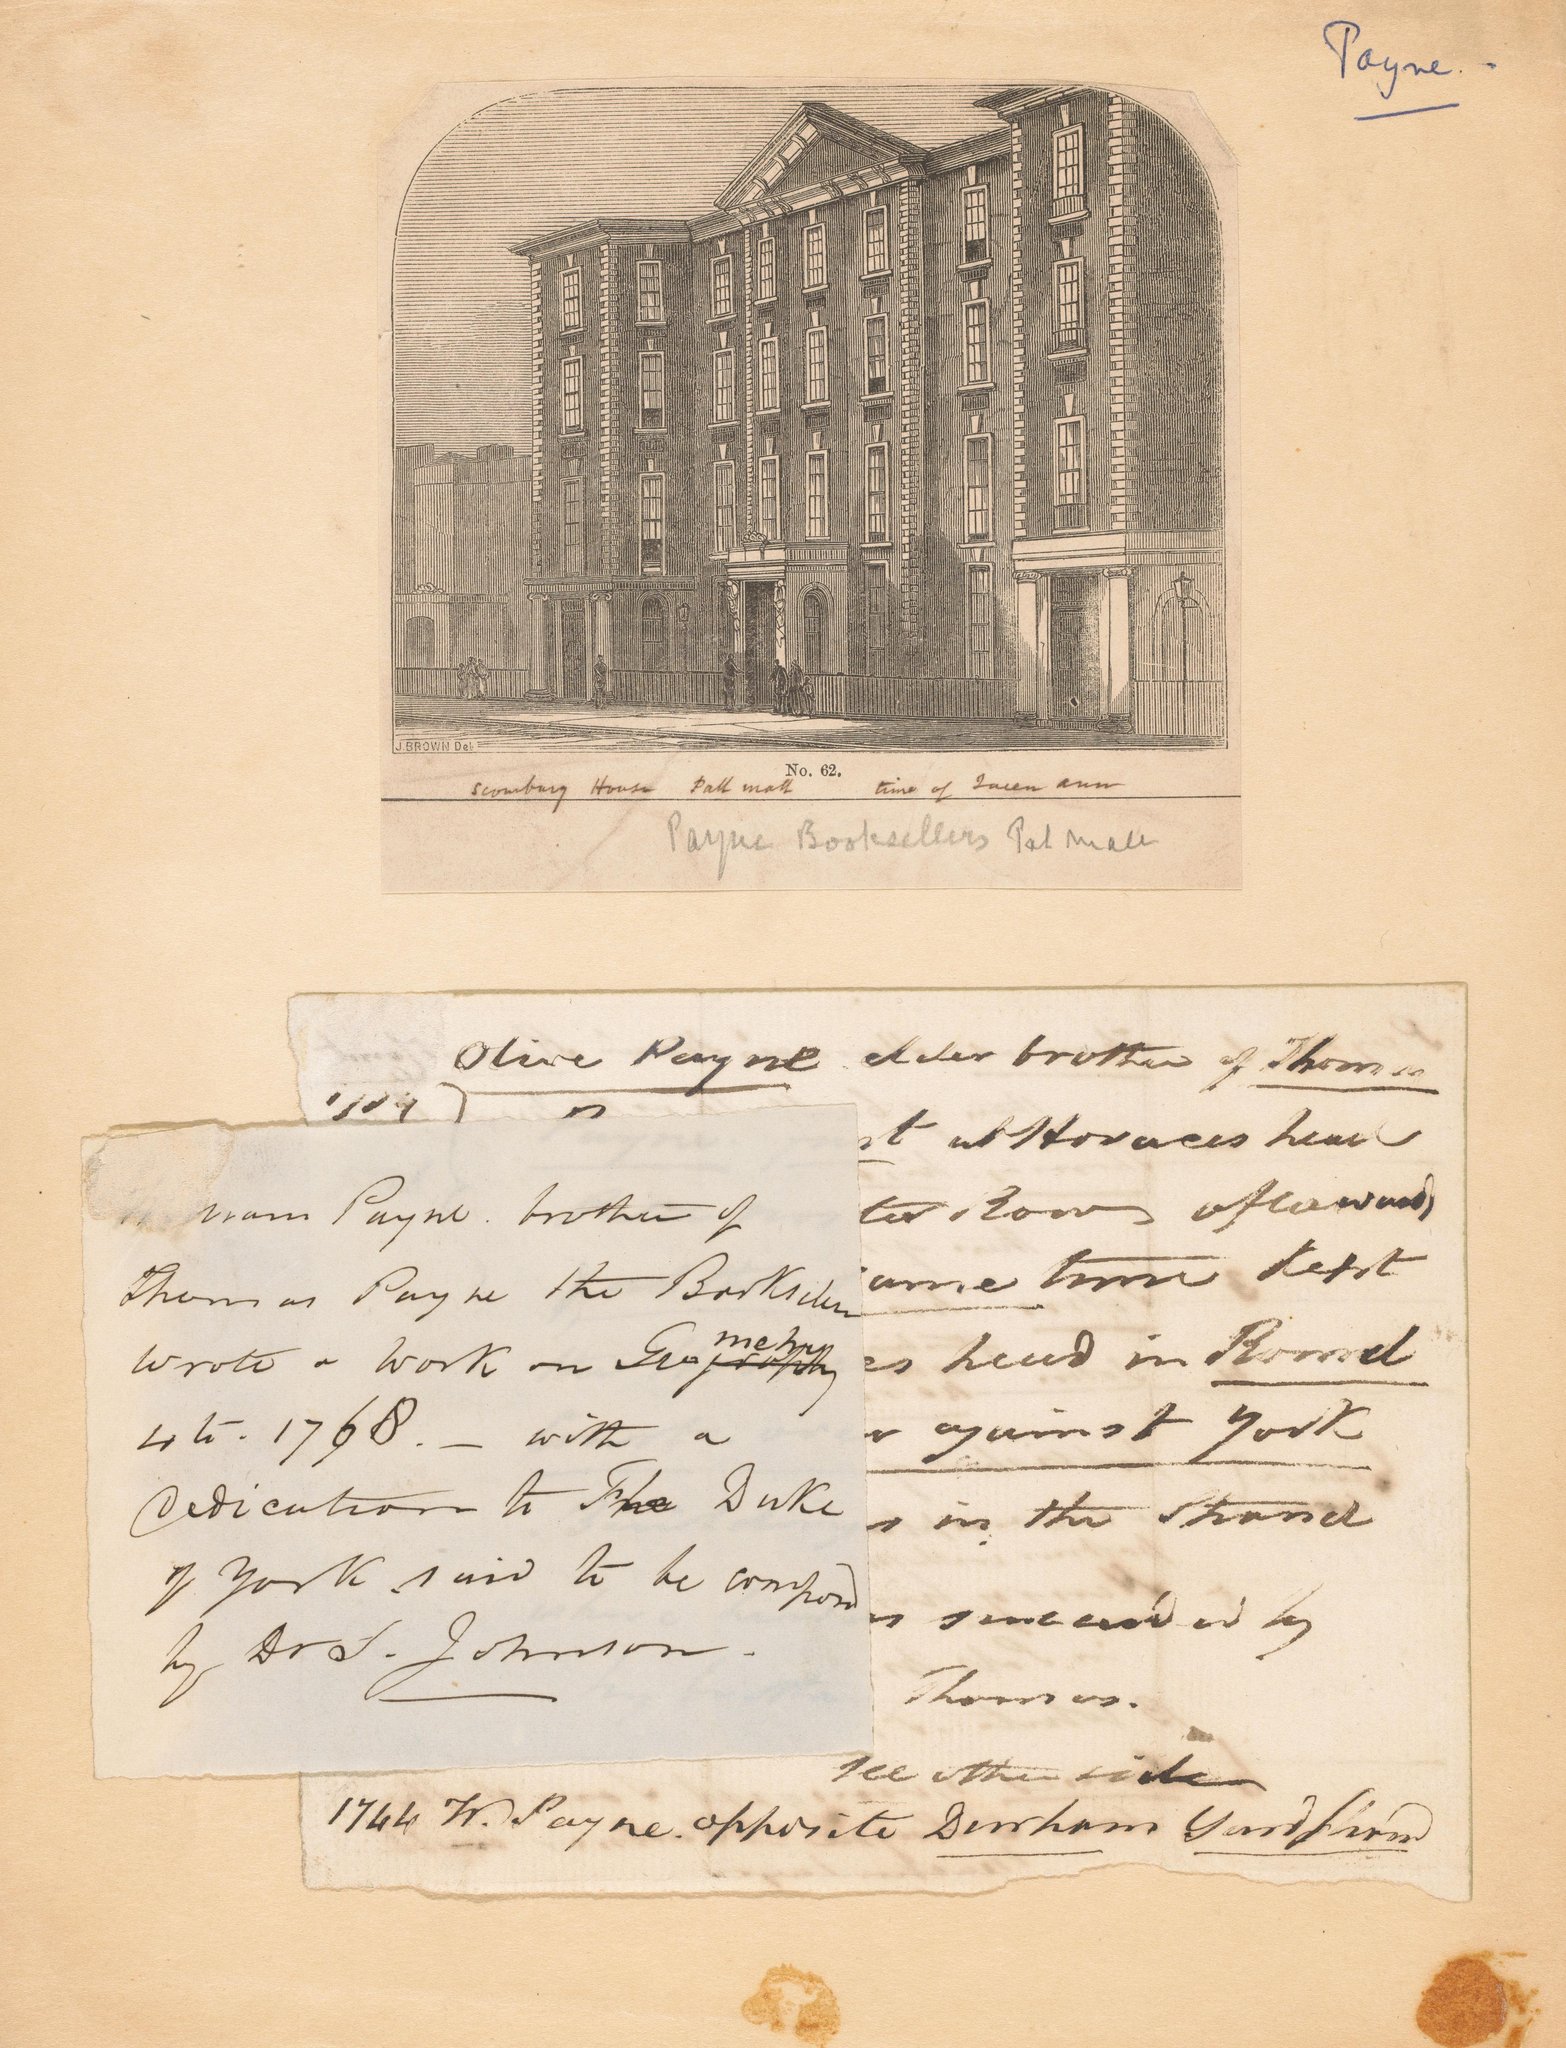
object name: illustration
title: Schomberg House te Londen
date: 1840-1859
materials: ink, paper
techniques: pen, snipping, engraving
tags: façade (of house or building)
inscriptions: annotation: ‘Scomburg House Pall Mall time of Queen Ann / Payne Booksellers Pal Mall’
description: Oorspronkelijk gebouwd voor Meinhardt Schomberg, derde Hertog van Schomberg (1641-1719). Vanaf 1806 was de boekhandel van Thomas Payne op dit adres gevestigd. Deze prent is afkomstig van een groter blad getiteld: 'The Houses and Shops of Old London', uitgegeven tussen 1840-1859. De prent is uitgeknipt en opgeplakt, samen met aantekeningen die betrekking hebben op de familie Payne.